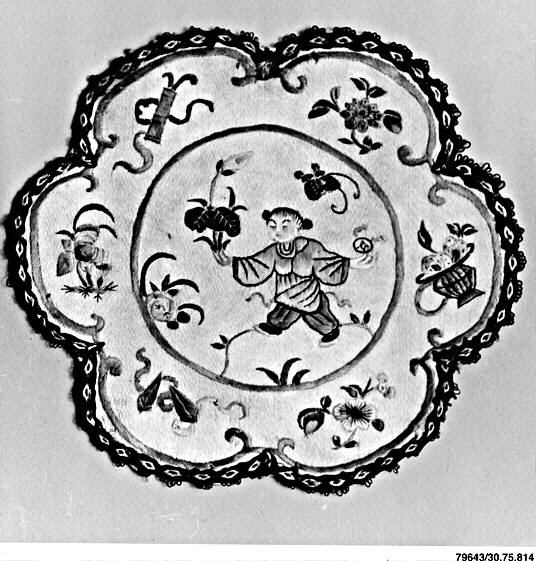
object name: medallion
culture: chinese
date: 1644-1911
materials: silk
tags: boys